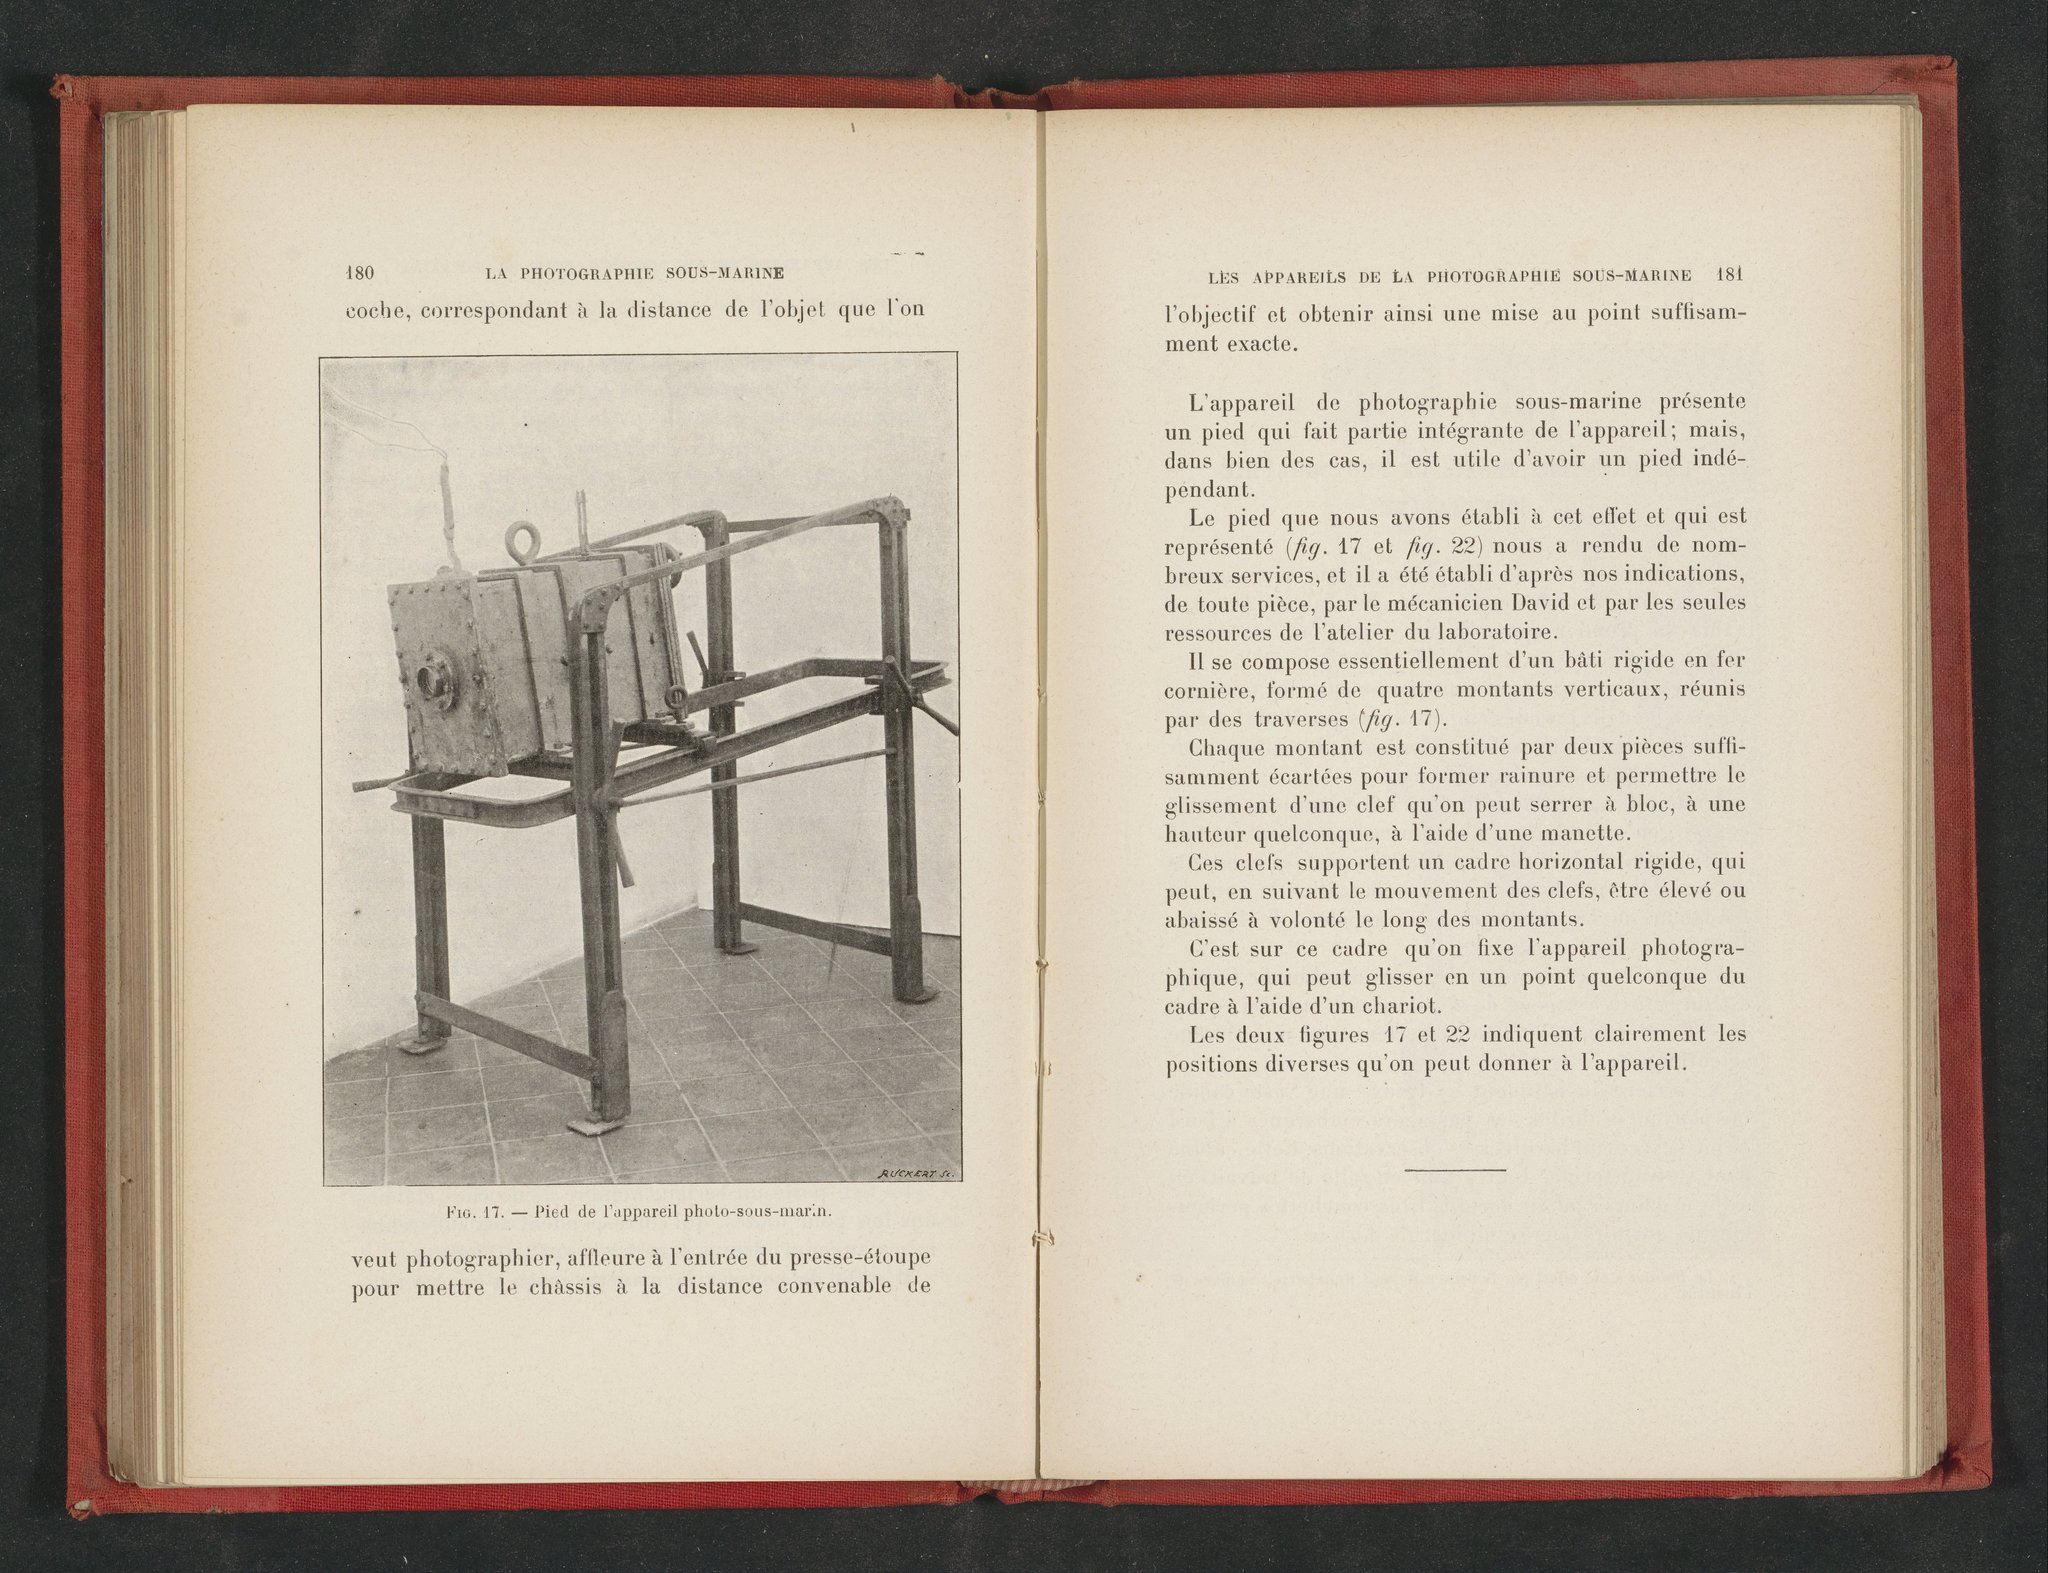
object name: page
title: Pied de l'appareil photo-sous-marin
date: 1890-1900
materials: paper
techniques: autotype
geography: france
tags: camera ~ photography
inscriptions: number: ‘Fig. 17.’